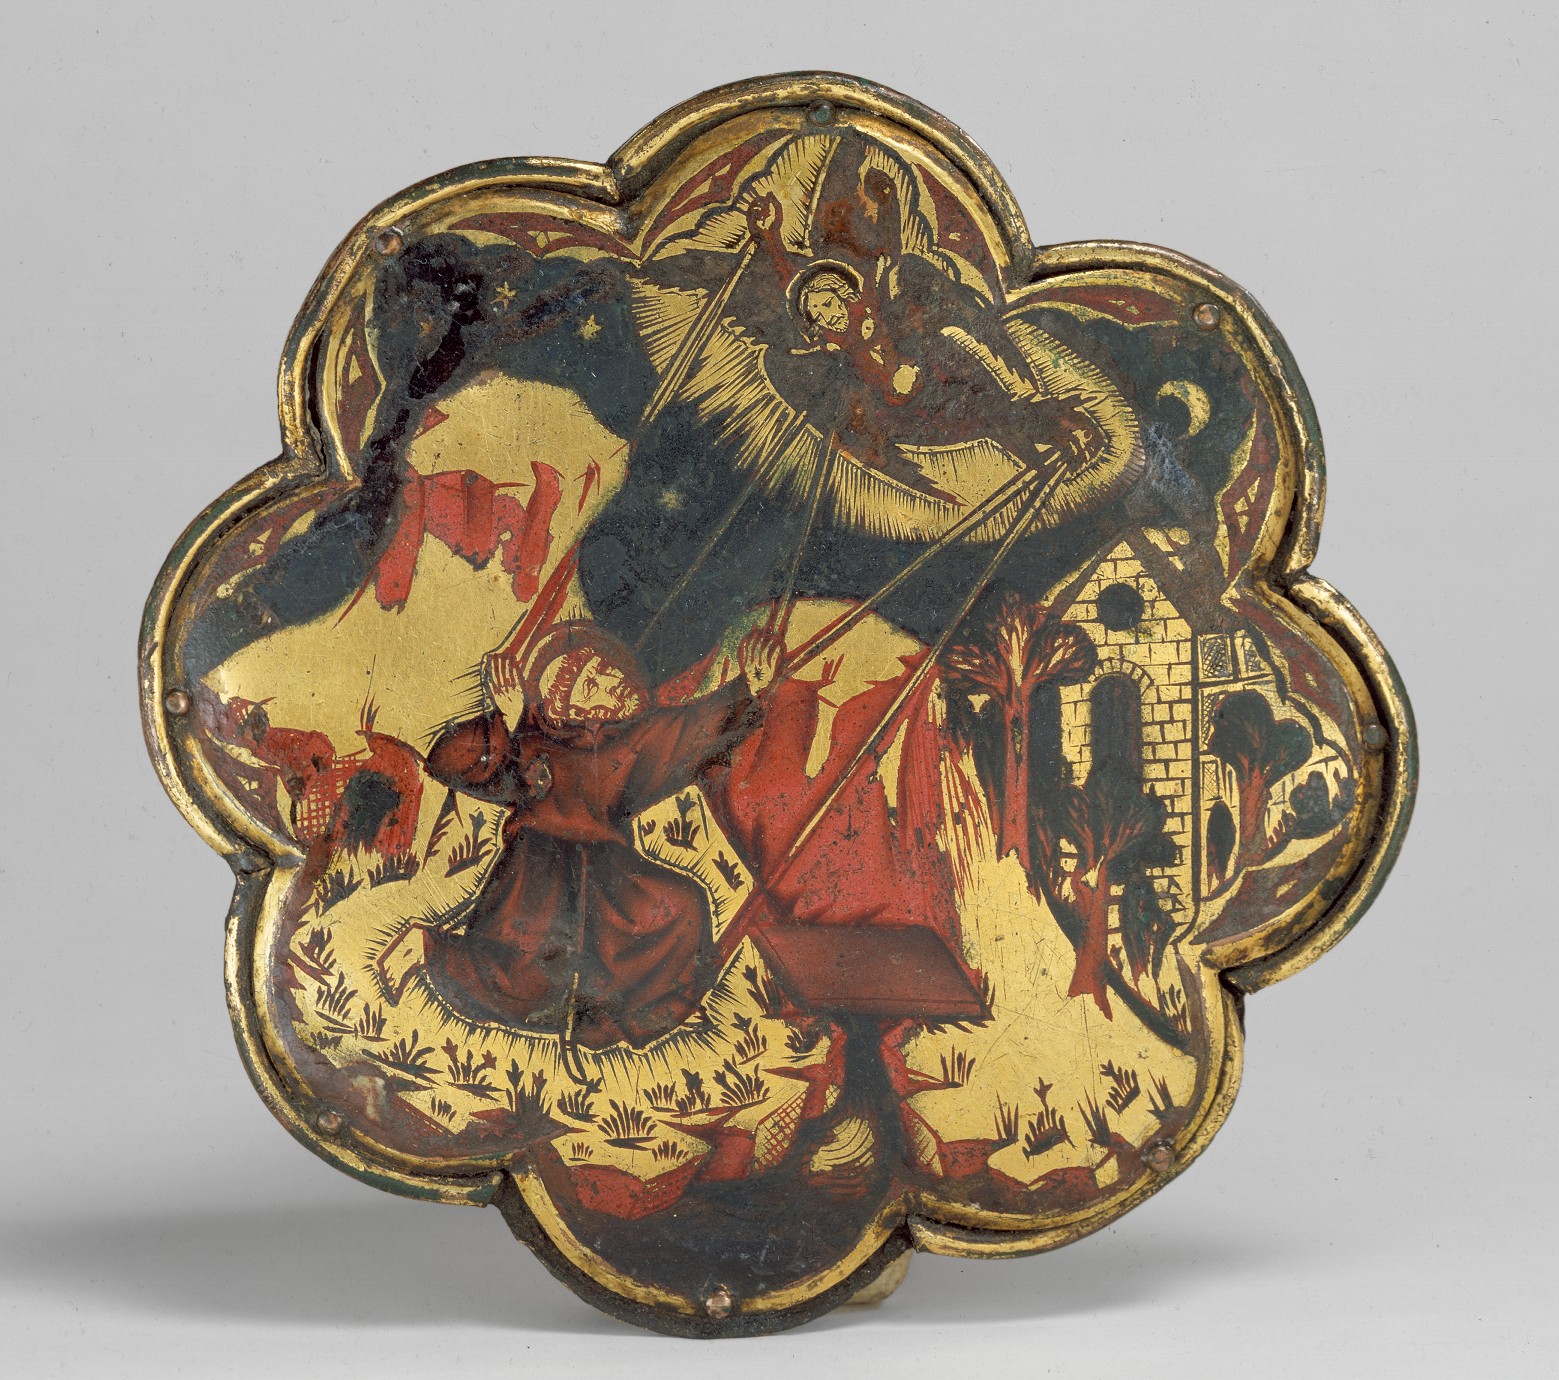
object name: morse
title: Morse with Saint Francis of Assisi Receiving the Stigmata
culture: italian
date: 1300-1350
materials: enamel, gilt copper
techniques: enamel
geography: italy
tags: angels,saint francis